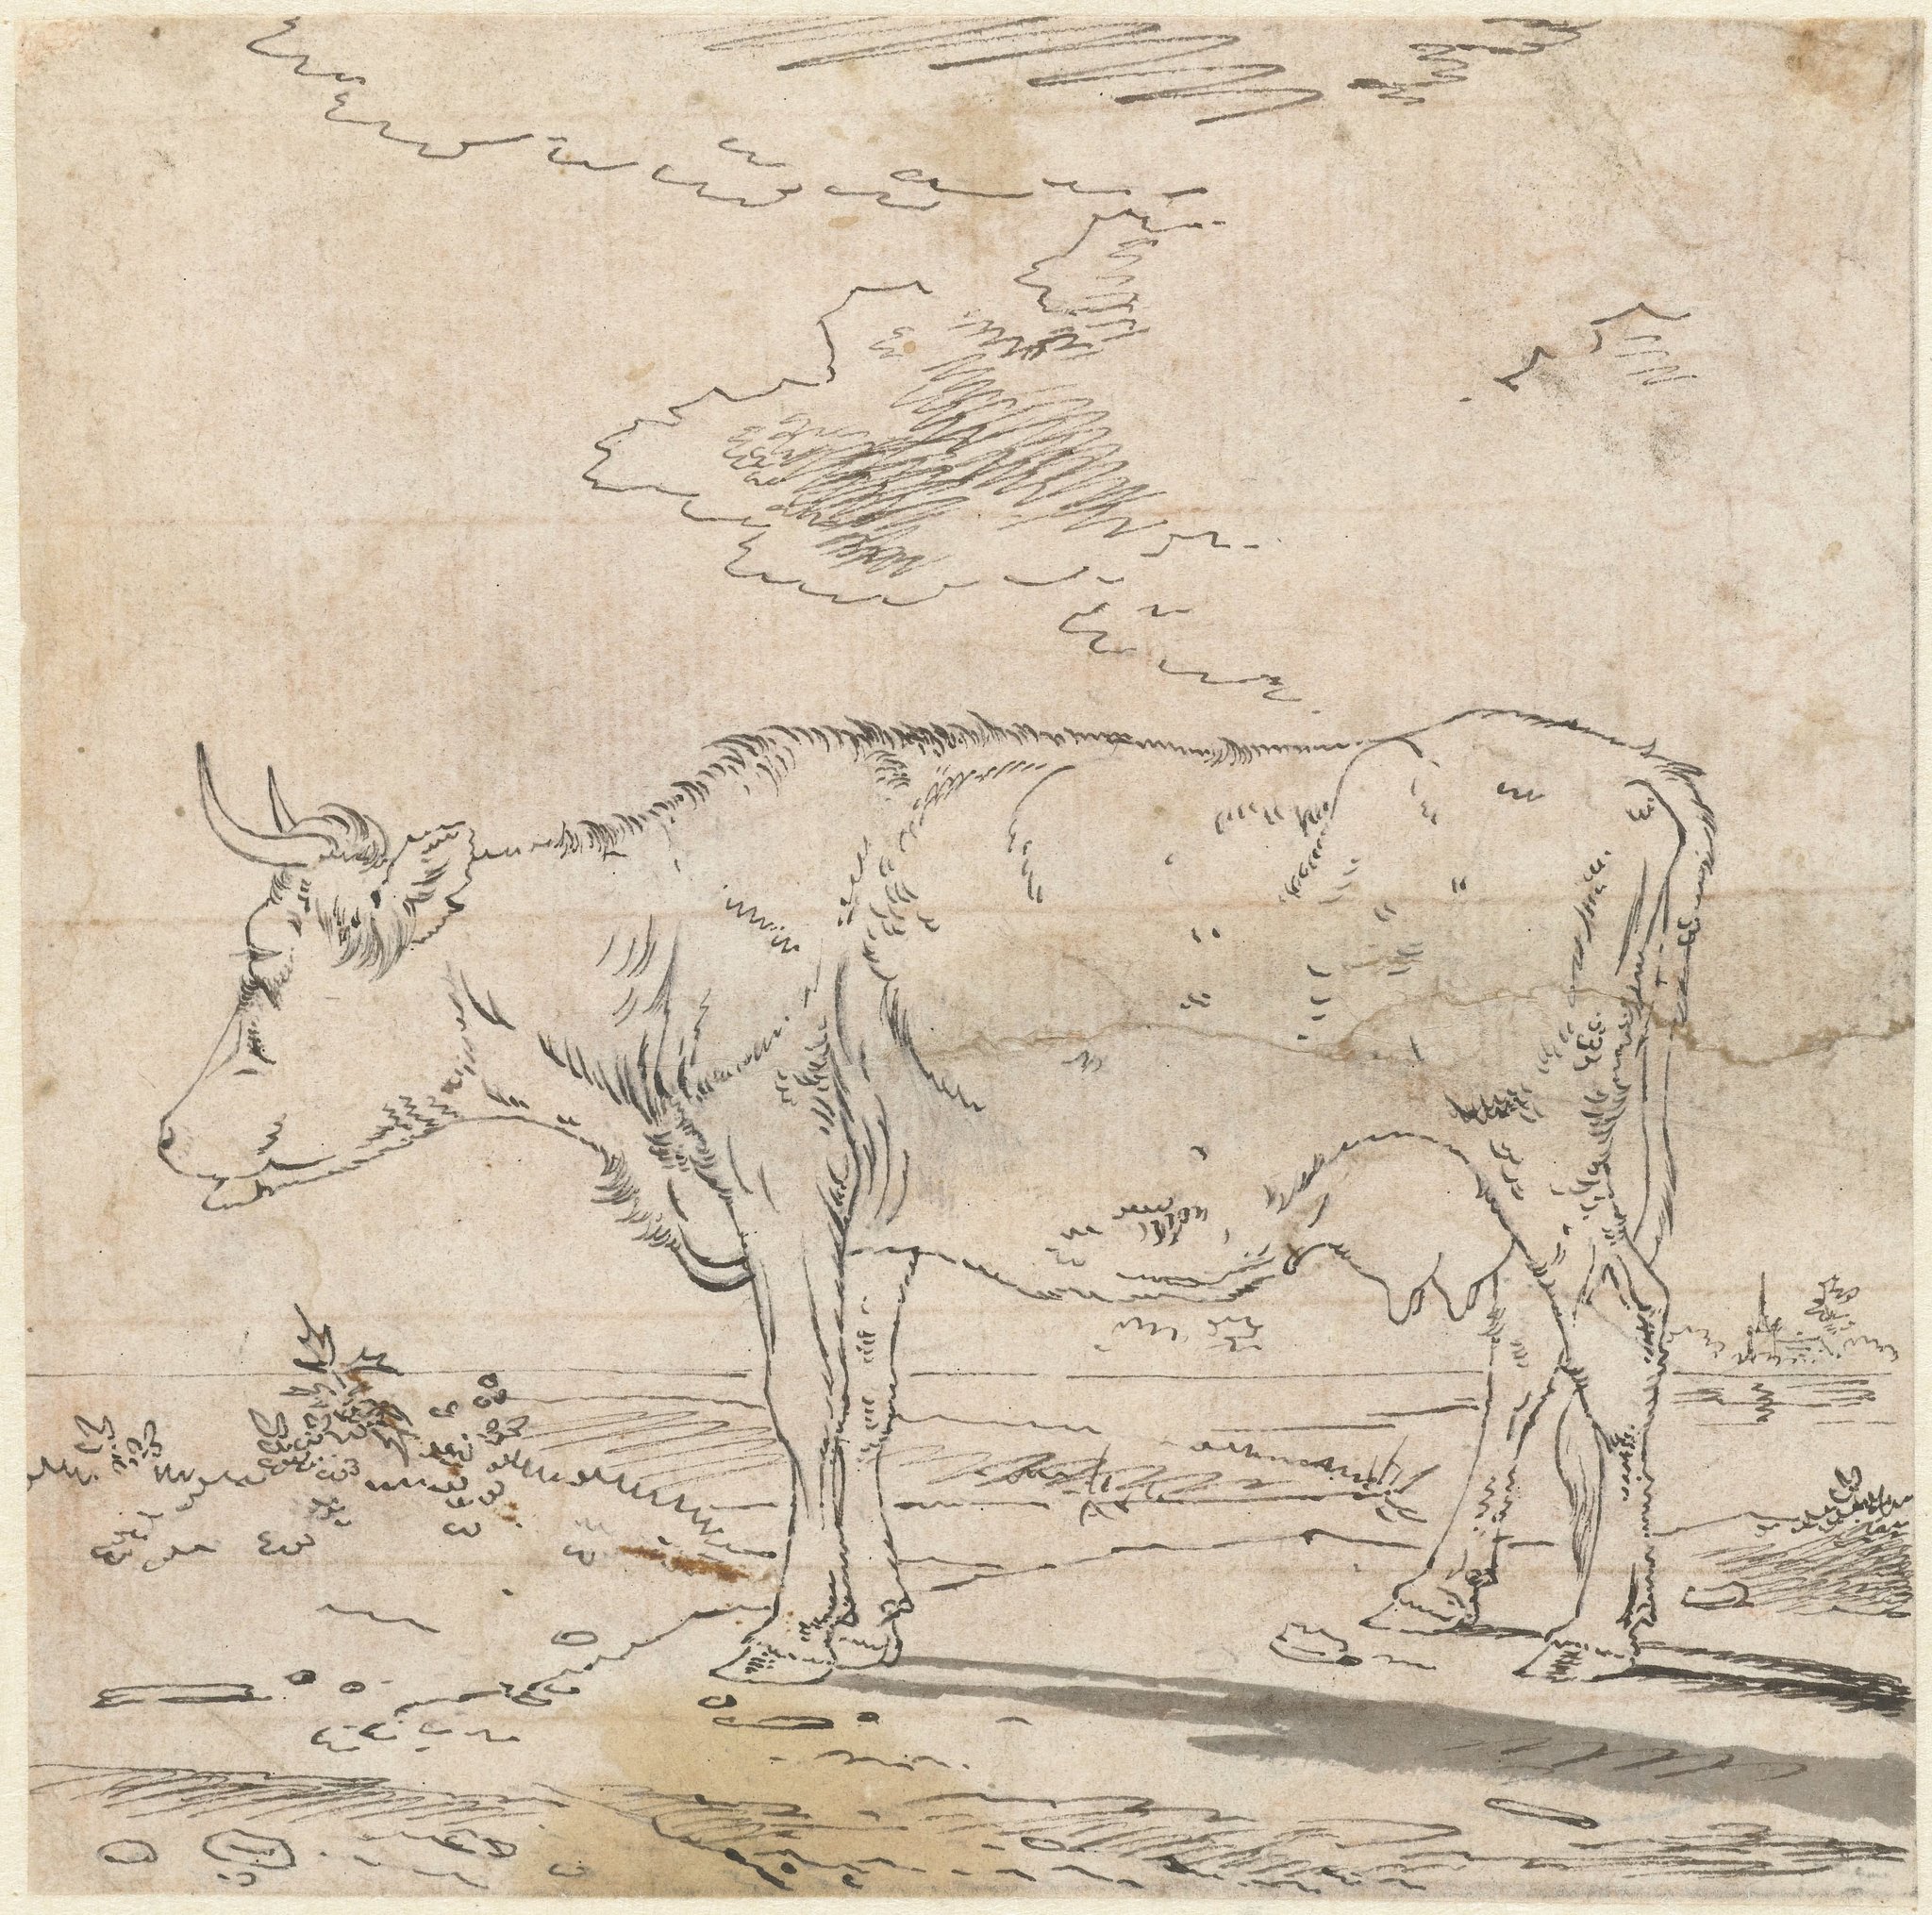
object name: design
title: Staande koe, naar links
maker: pieter janson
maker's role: draughtsman, print maker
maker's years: 1765-1851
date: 1775-1851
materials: chalk, ink, paper, pencil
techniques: pen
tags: cow